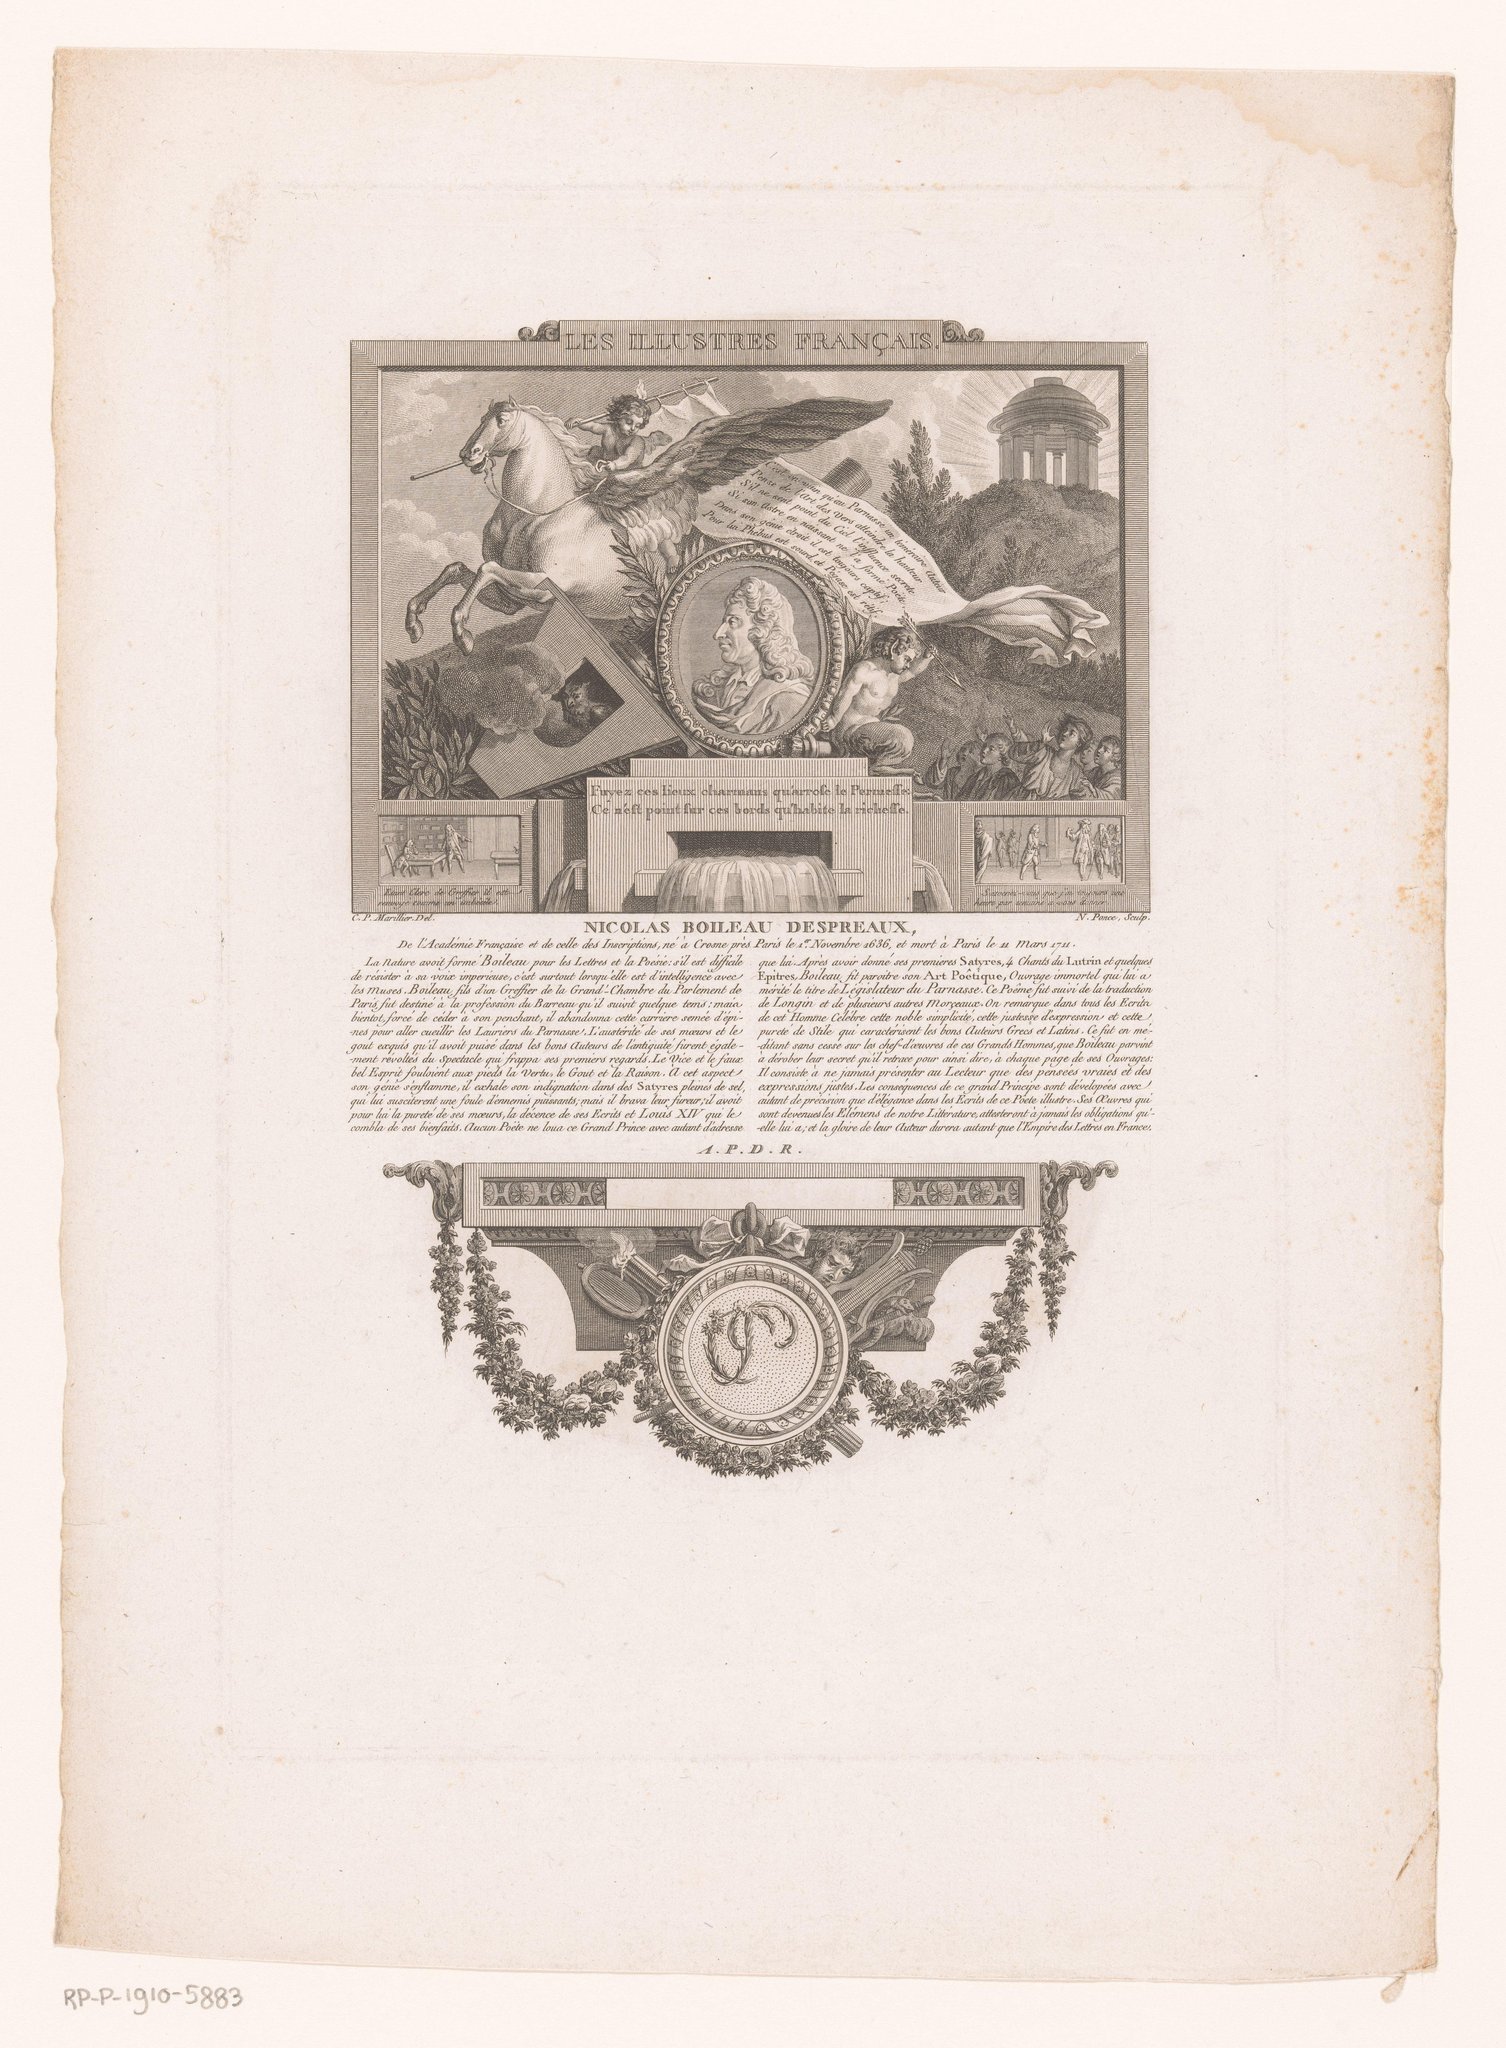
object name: print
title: Portretten van Franse historische figuren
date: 1790-1816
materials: paper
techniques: engraving, etching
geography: france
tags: paris, nicolas boileau, pegasus, the winged horse, historical persons, portrait of a writer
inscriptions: collector's mark: Lugt 2228